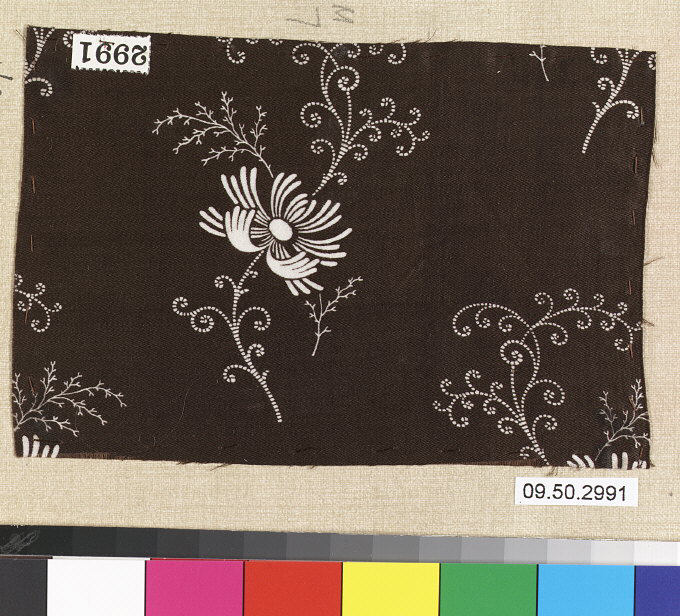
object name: piece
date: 1801-1900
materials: cotton